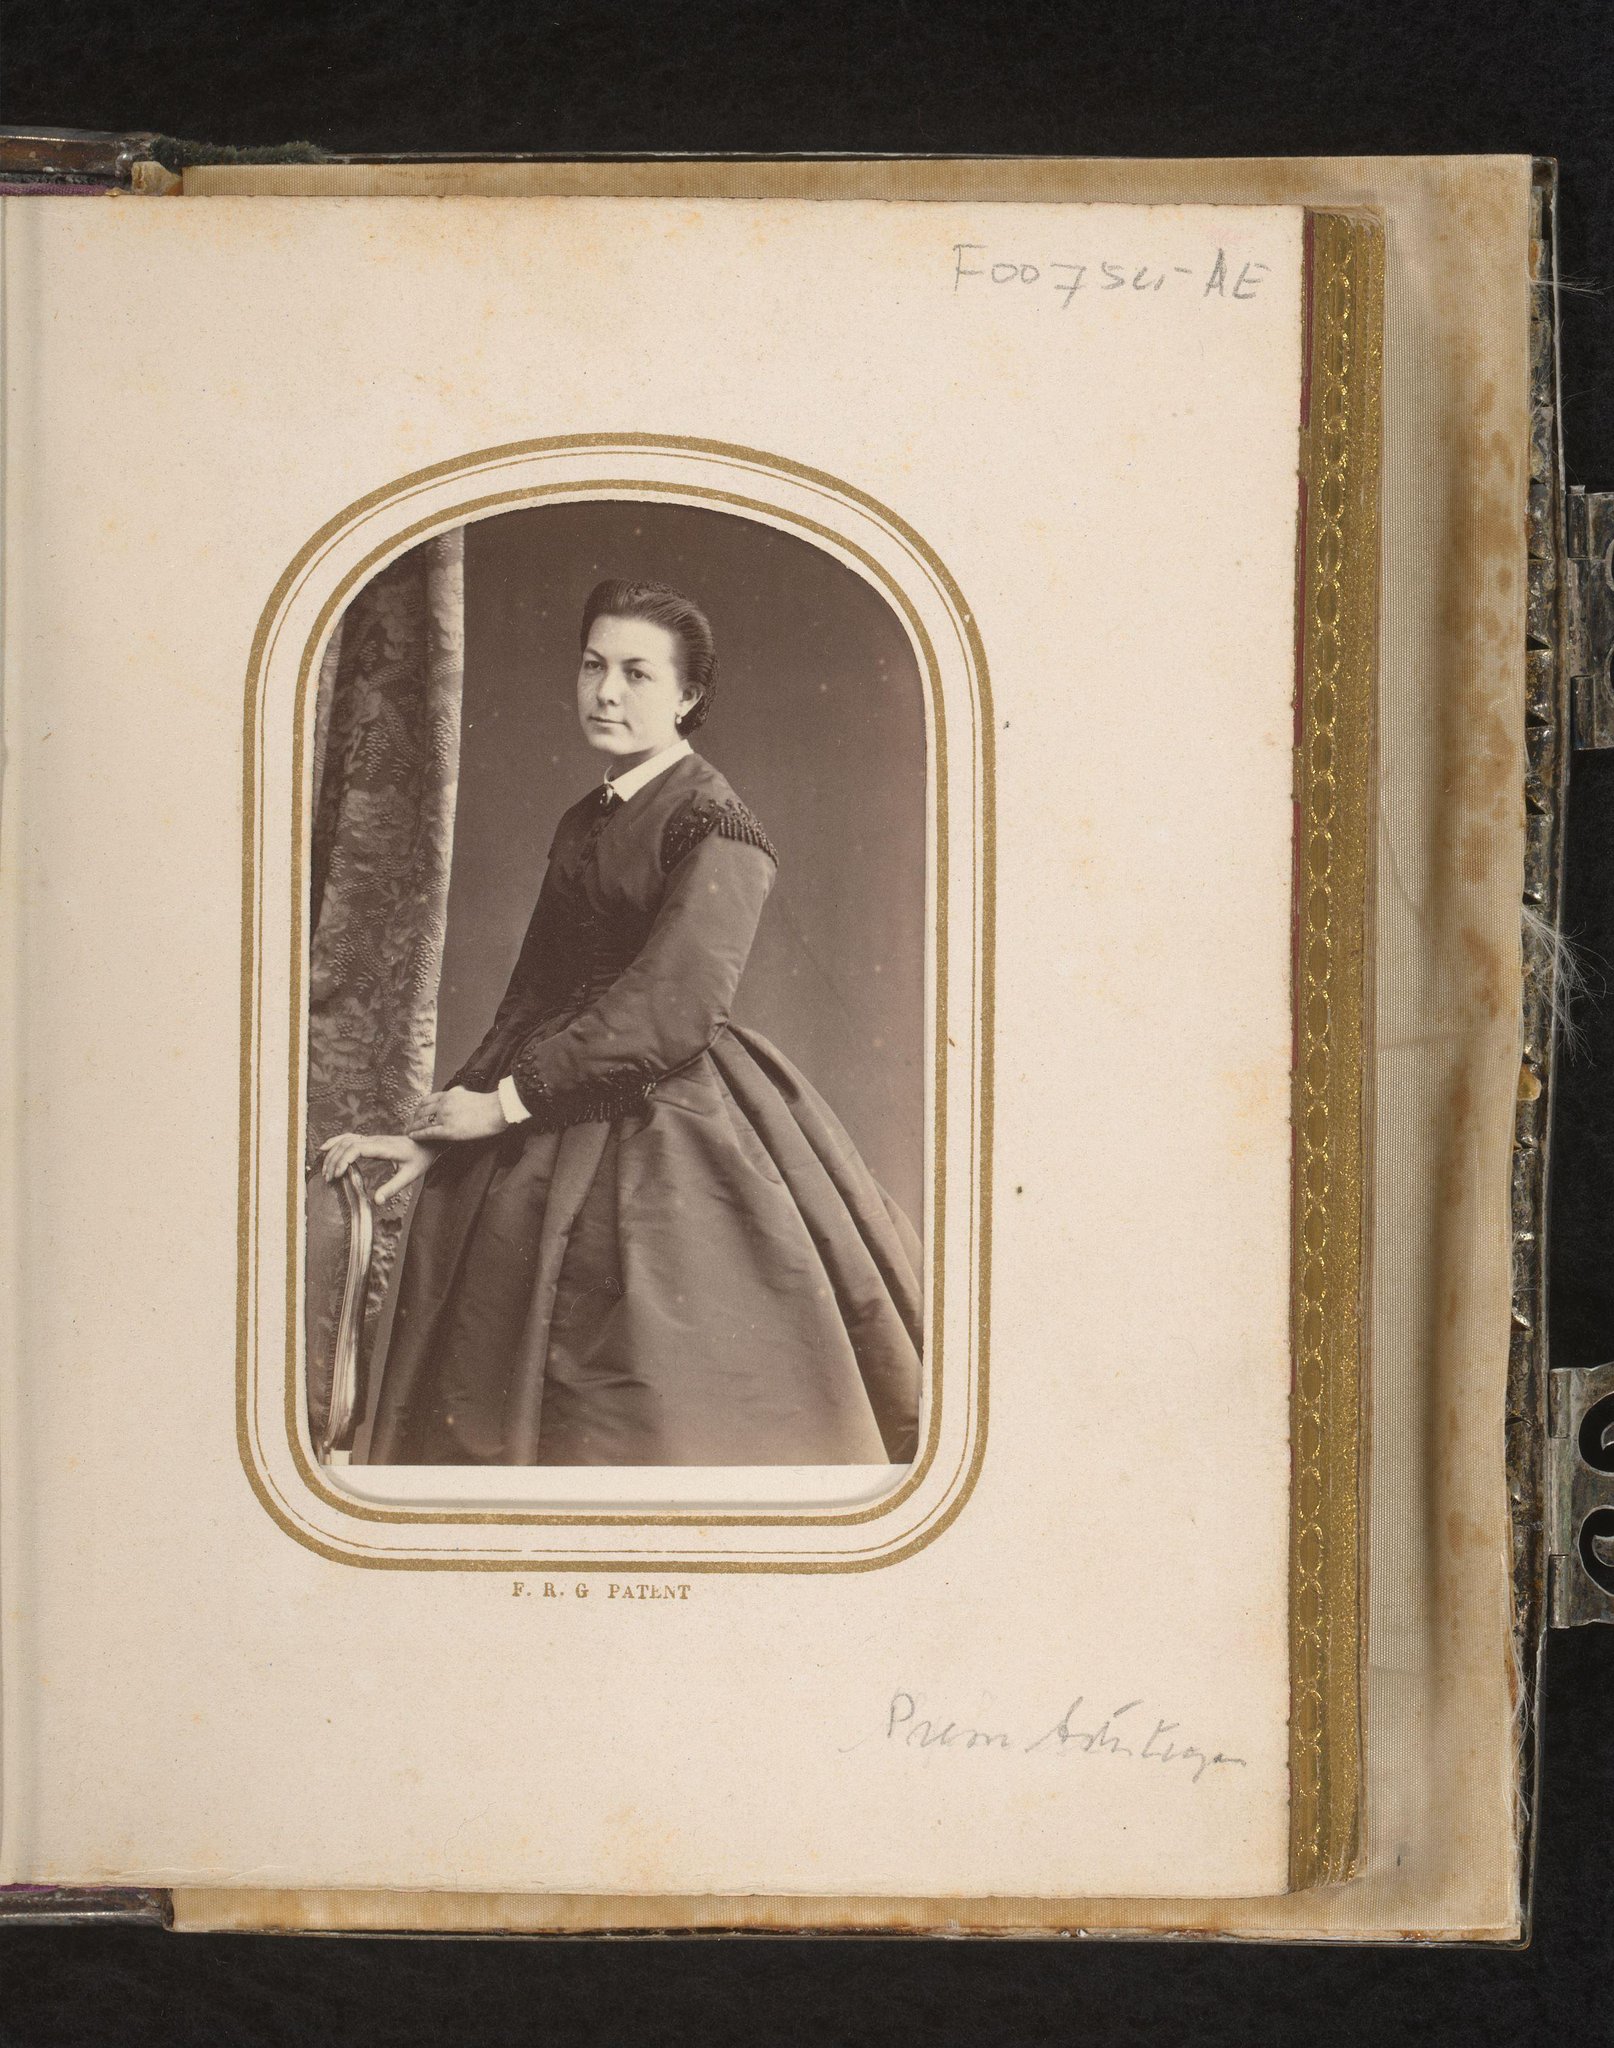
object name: photograph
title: Portret van een staande vrouw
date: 1855-1880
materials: cardboard, photographic support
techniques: albumen print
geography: paris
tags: historical persons - bb - woman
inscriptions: inscription: ‘Photographie/ de/ La Presse Artistique/ 123, rue Montmartre, 123/ Paris’